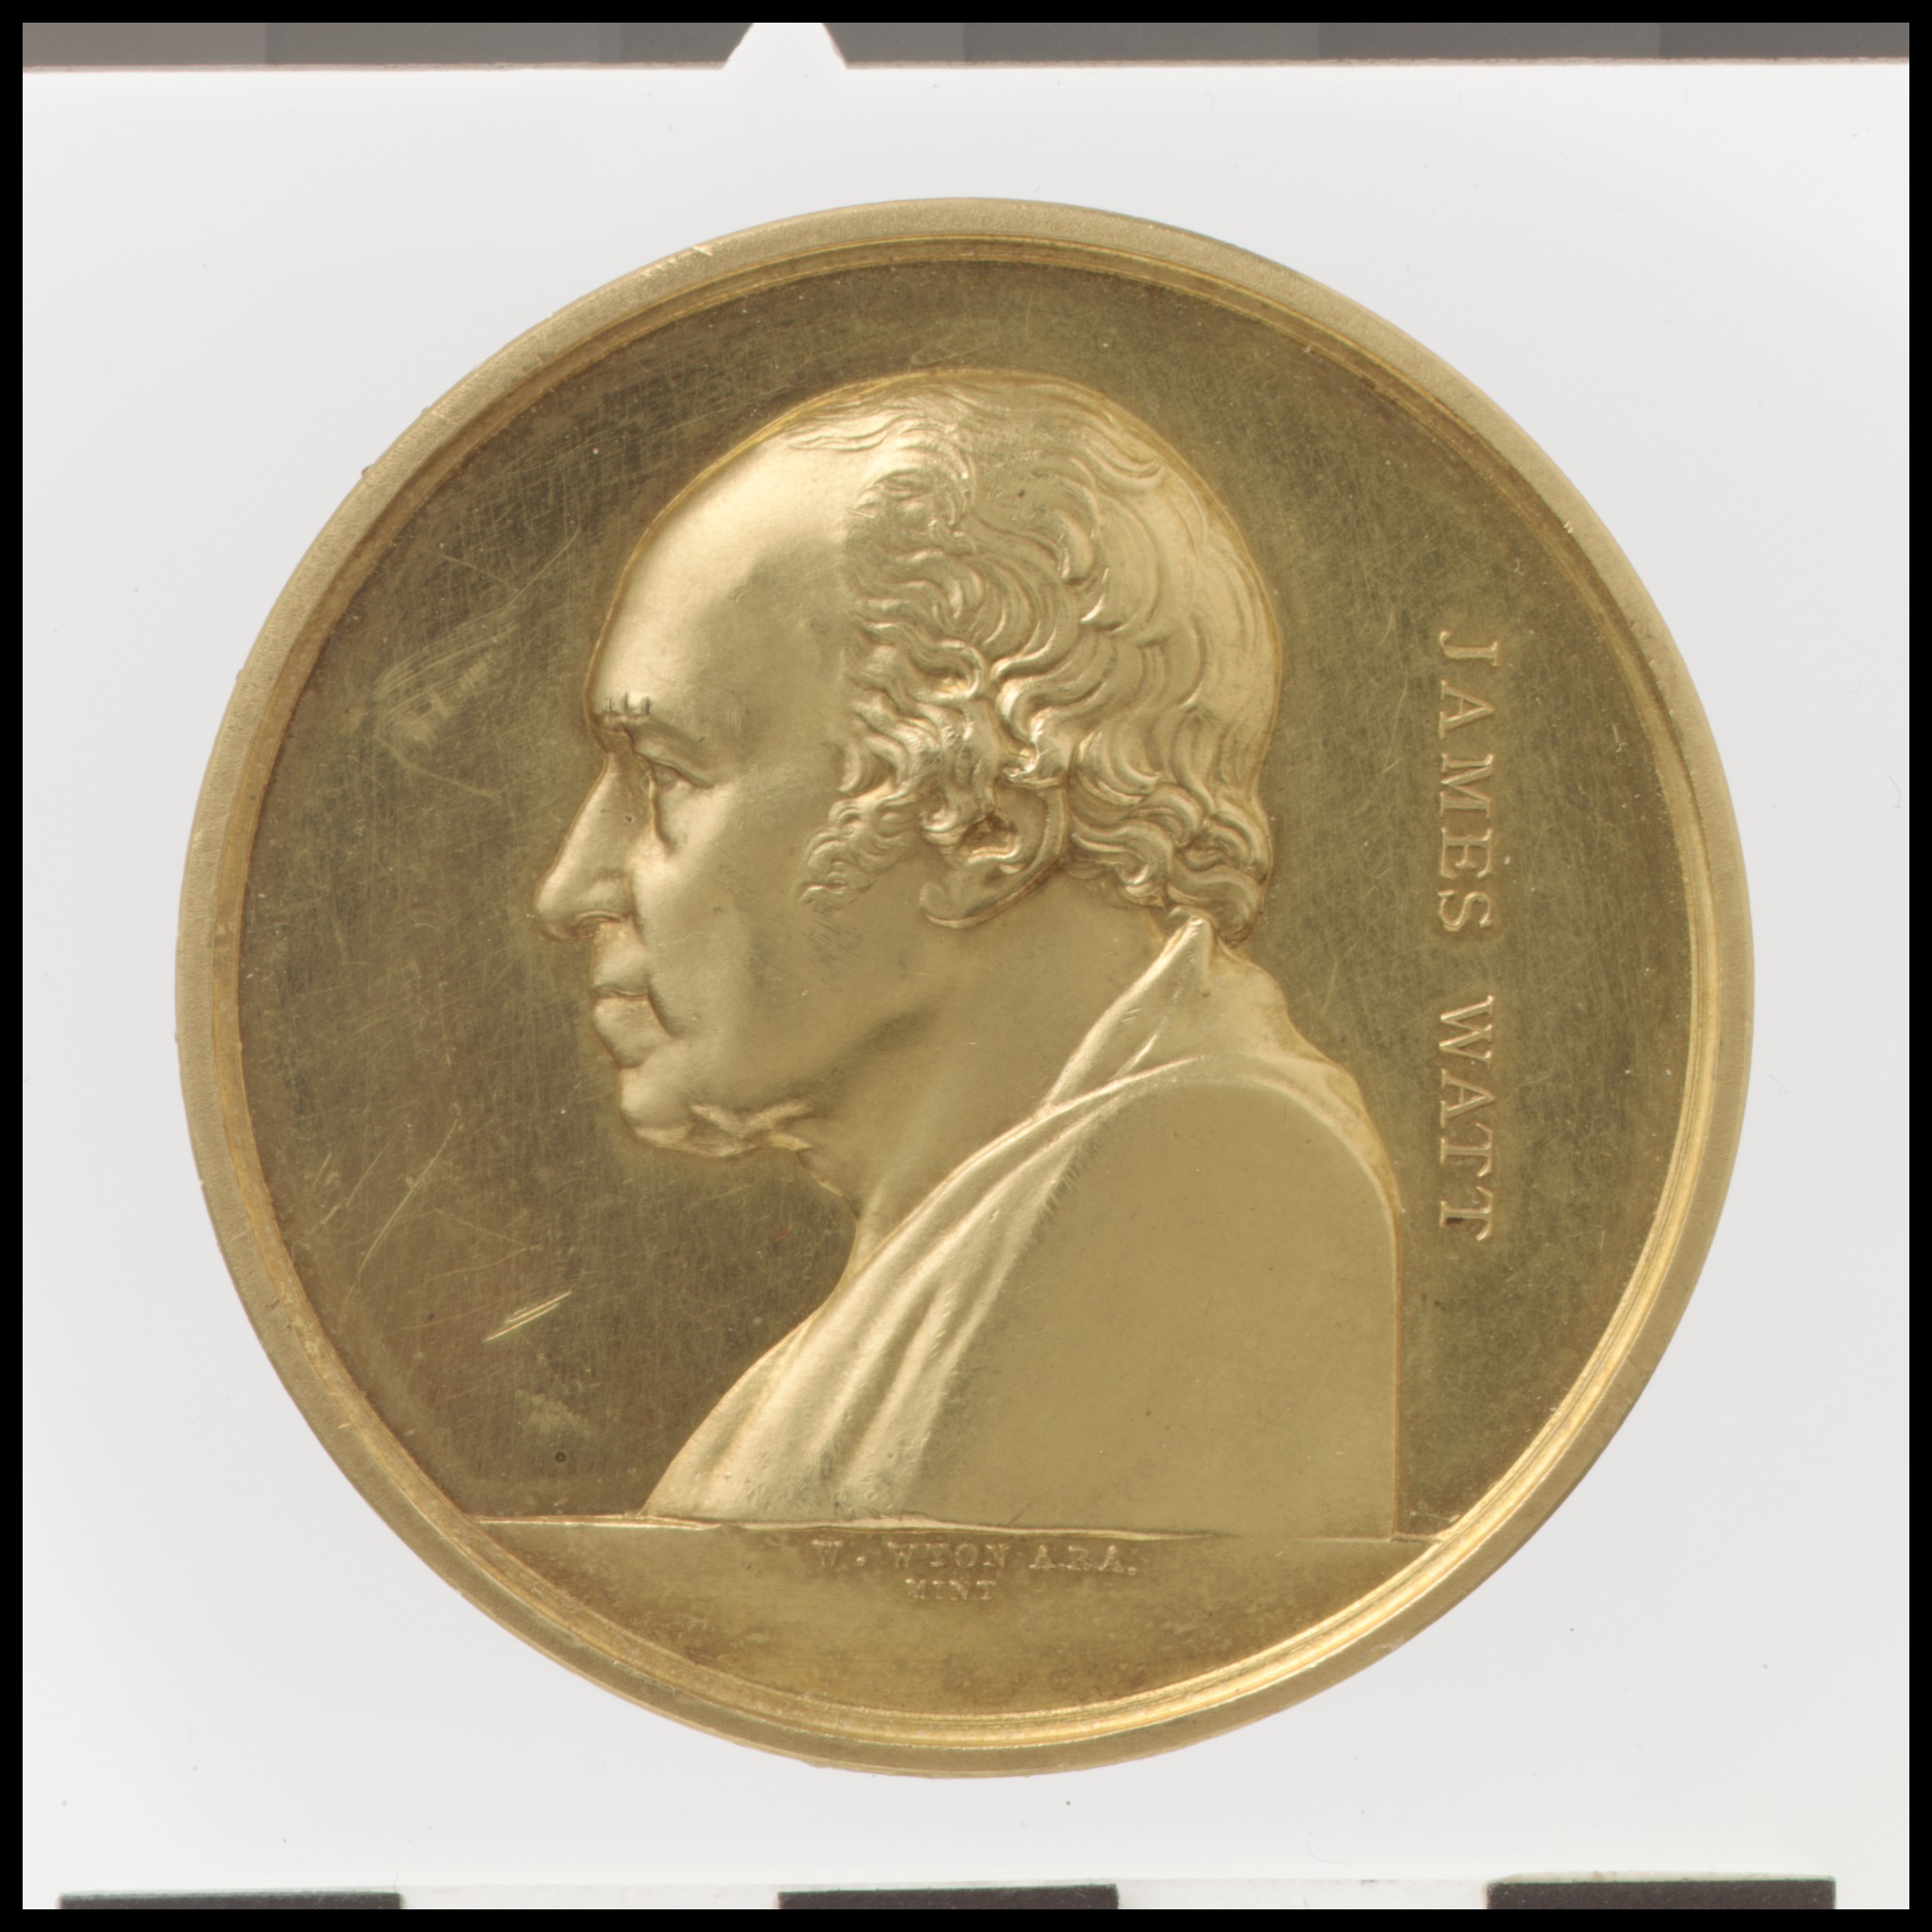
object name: medal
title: James Watt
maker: william wyon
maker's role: artist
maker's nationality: british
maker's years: 1795-1851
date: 1833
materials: gold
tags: men,profiles